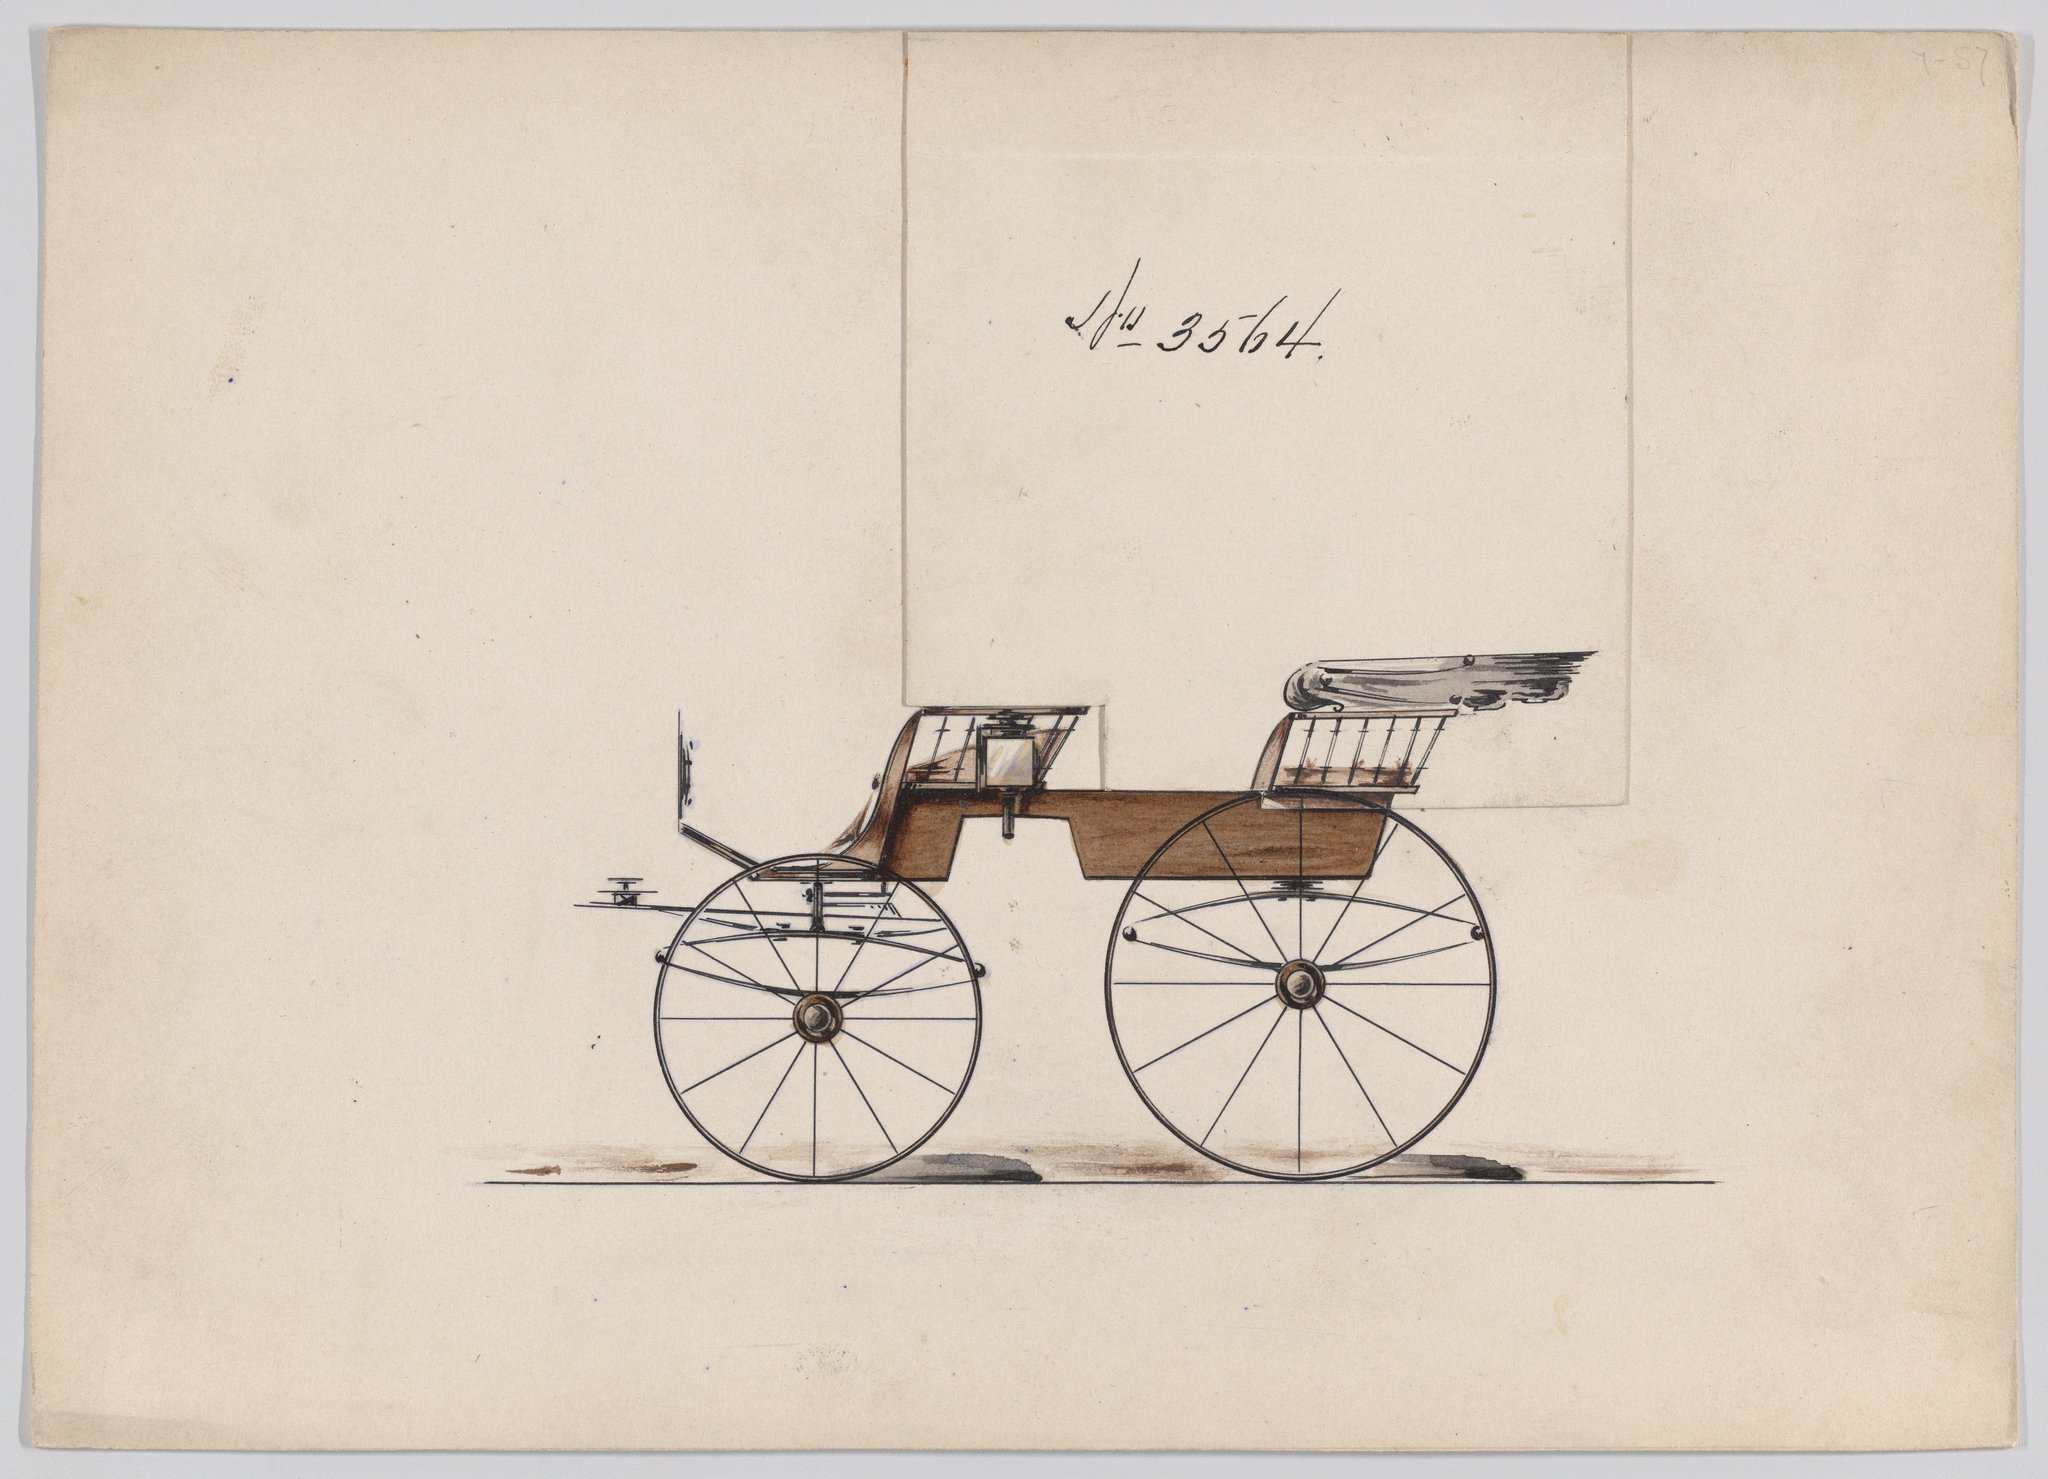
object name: drawing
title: Design for 2 seat Phaeton, no. 3564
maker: brewster & co.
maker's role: manufacturer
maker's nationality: american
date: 1880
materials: gouache, gum arabic, ink, watercolor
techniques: pen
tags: carriages